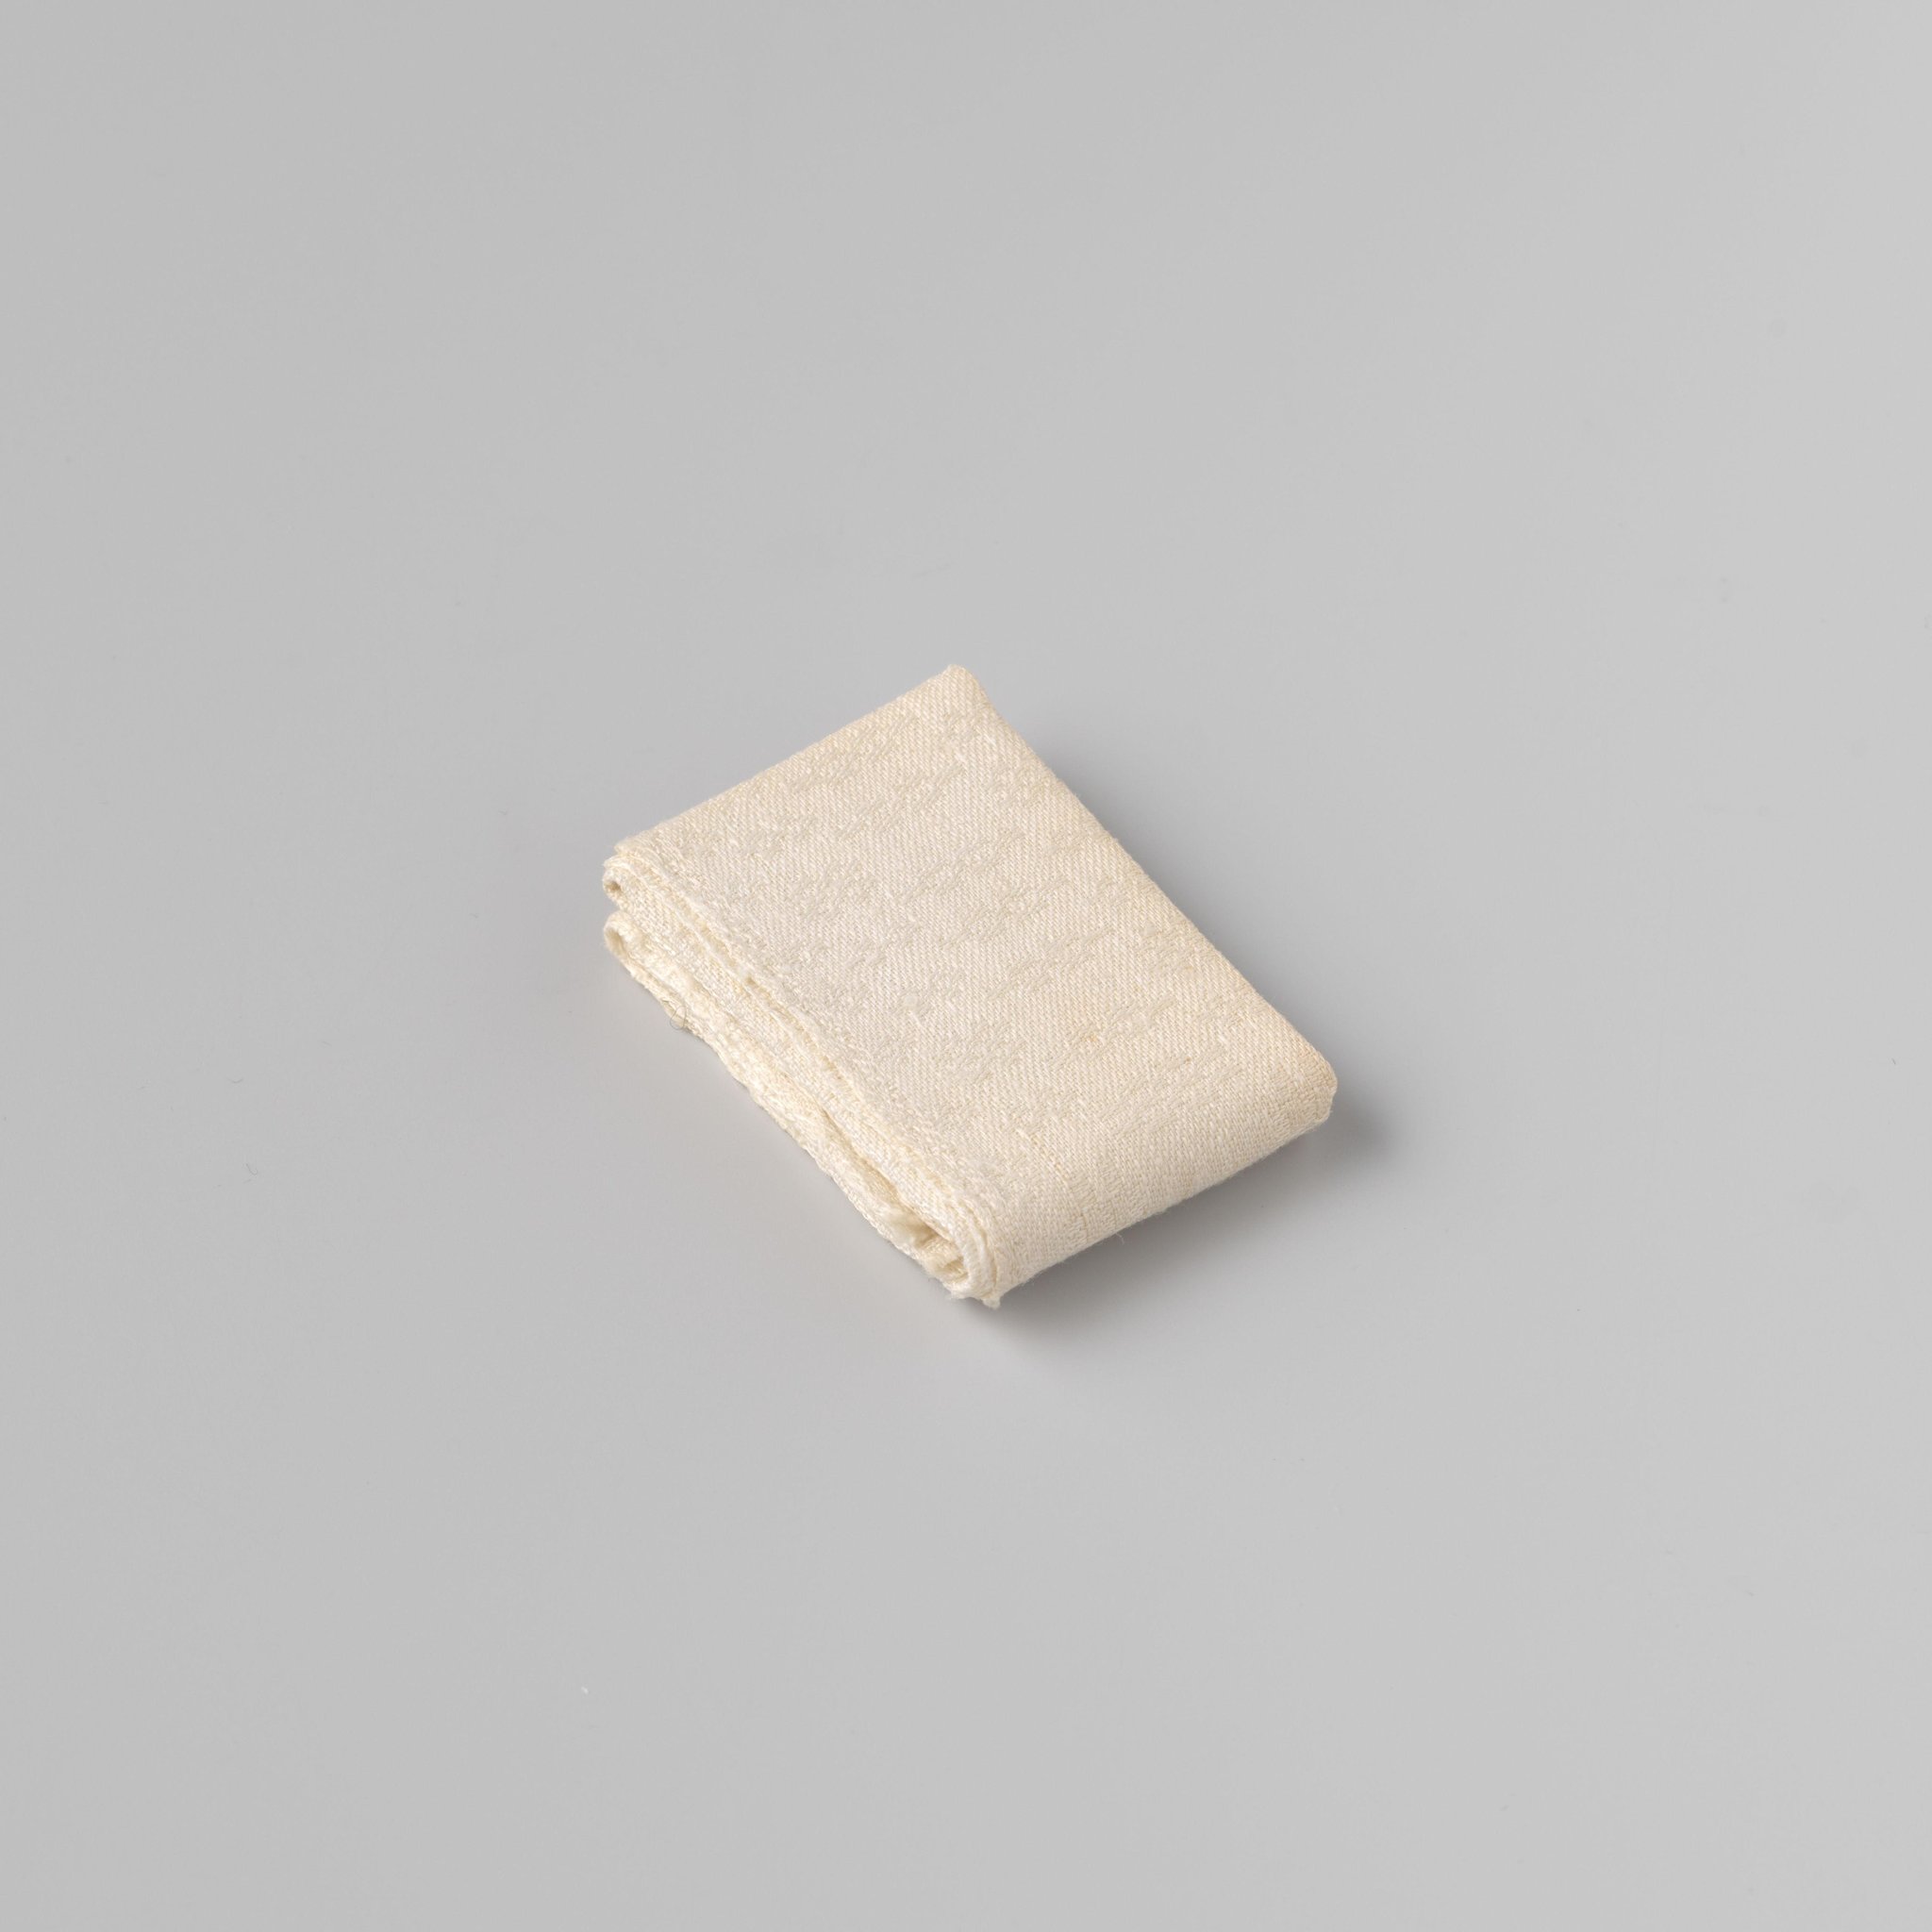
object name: dwaal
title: Linnen servet van damastweefsel met pellenpatroon (motief III), geen zomen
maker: Anonymous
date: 1690-1710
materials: linen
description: Servet, damastweefsel met pellenpatroon met randmotief (motief III), met twee zelfkanten geweven, geen zomen.